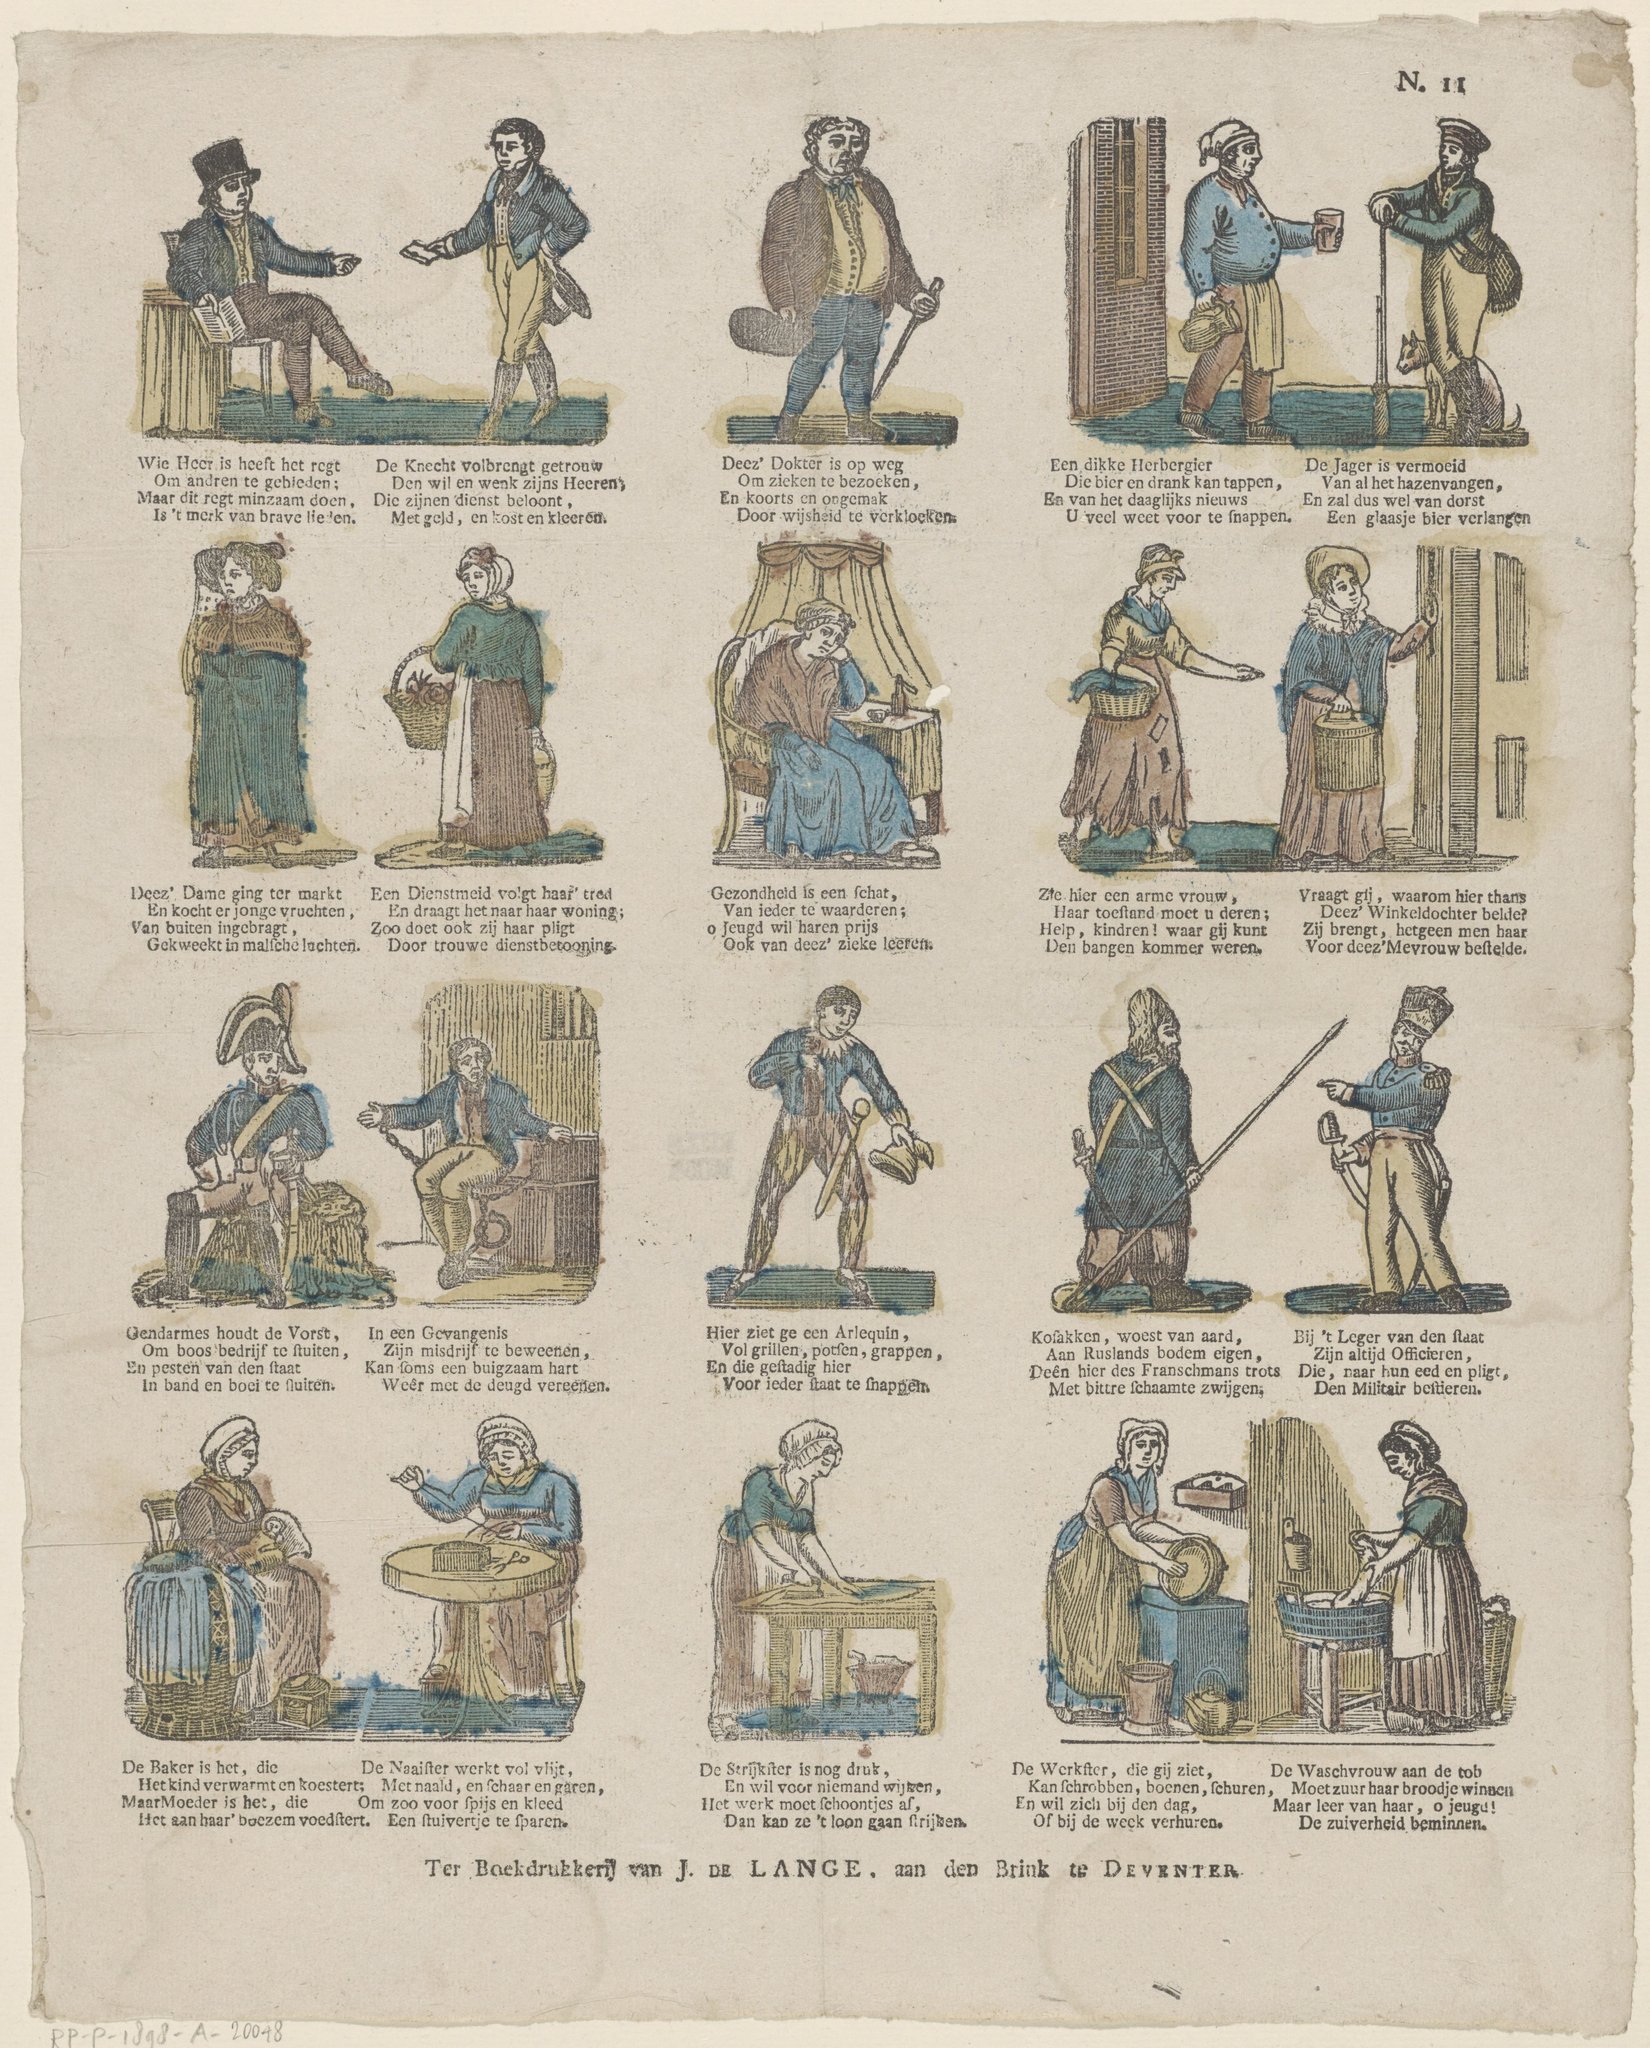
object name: popular print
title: Beroepen en bezigheden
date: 1822-1849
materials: paper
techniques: colour, letterpress printing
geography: netherlands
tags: human types, working class, labourers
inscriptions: collector's mark: Lugt 2166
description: Blad met 15 voorstellingen van verschillende beroepen en bezigheden voor mannen en vrouwen. Onder elke figuur een vierregelig vers. Genummerd rechtsboven: N. 11.